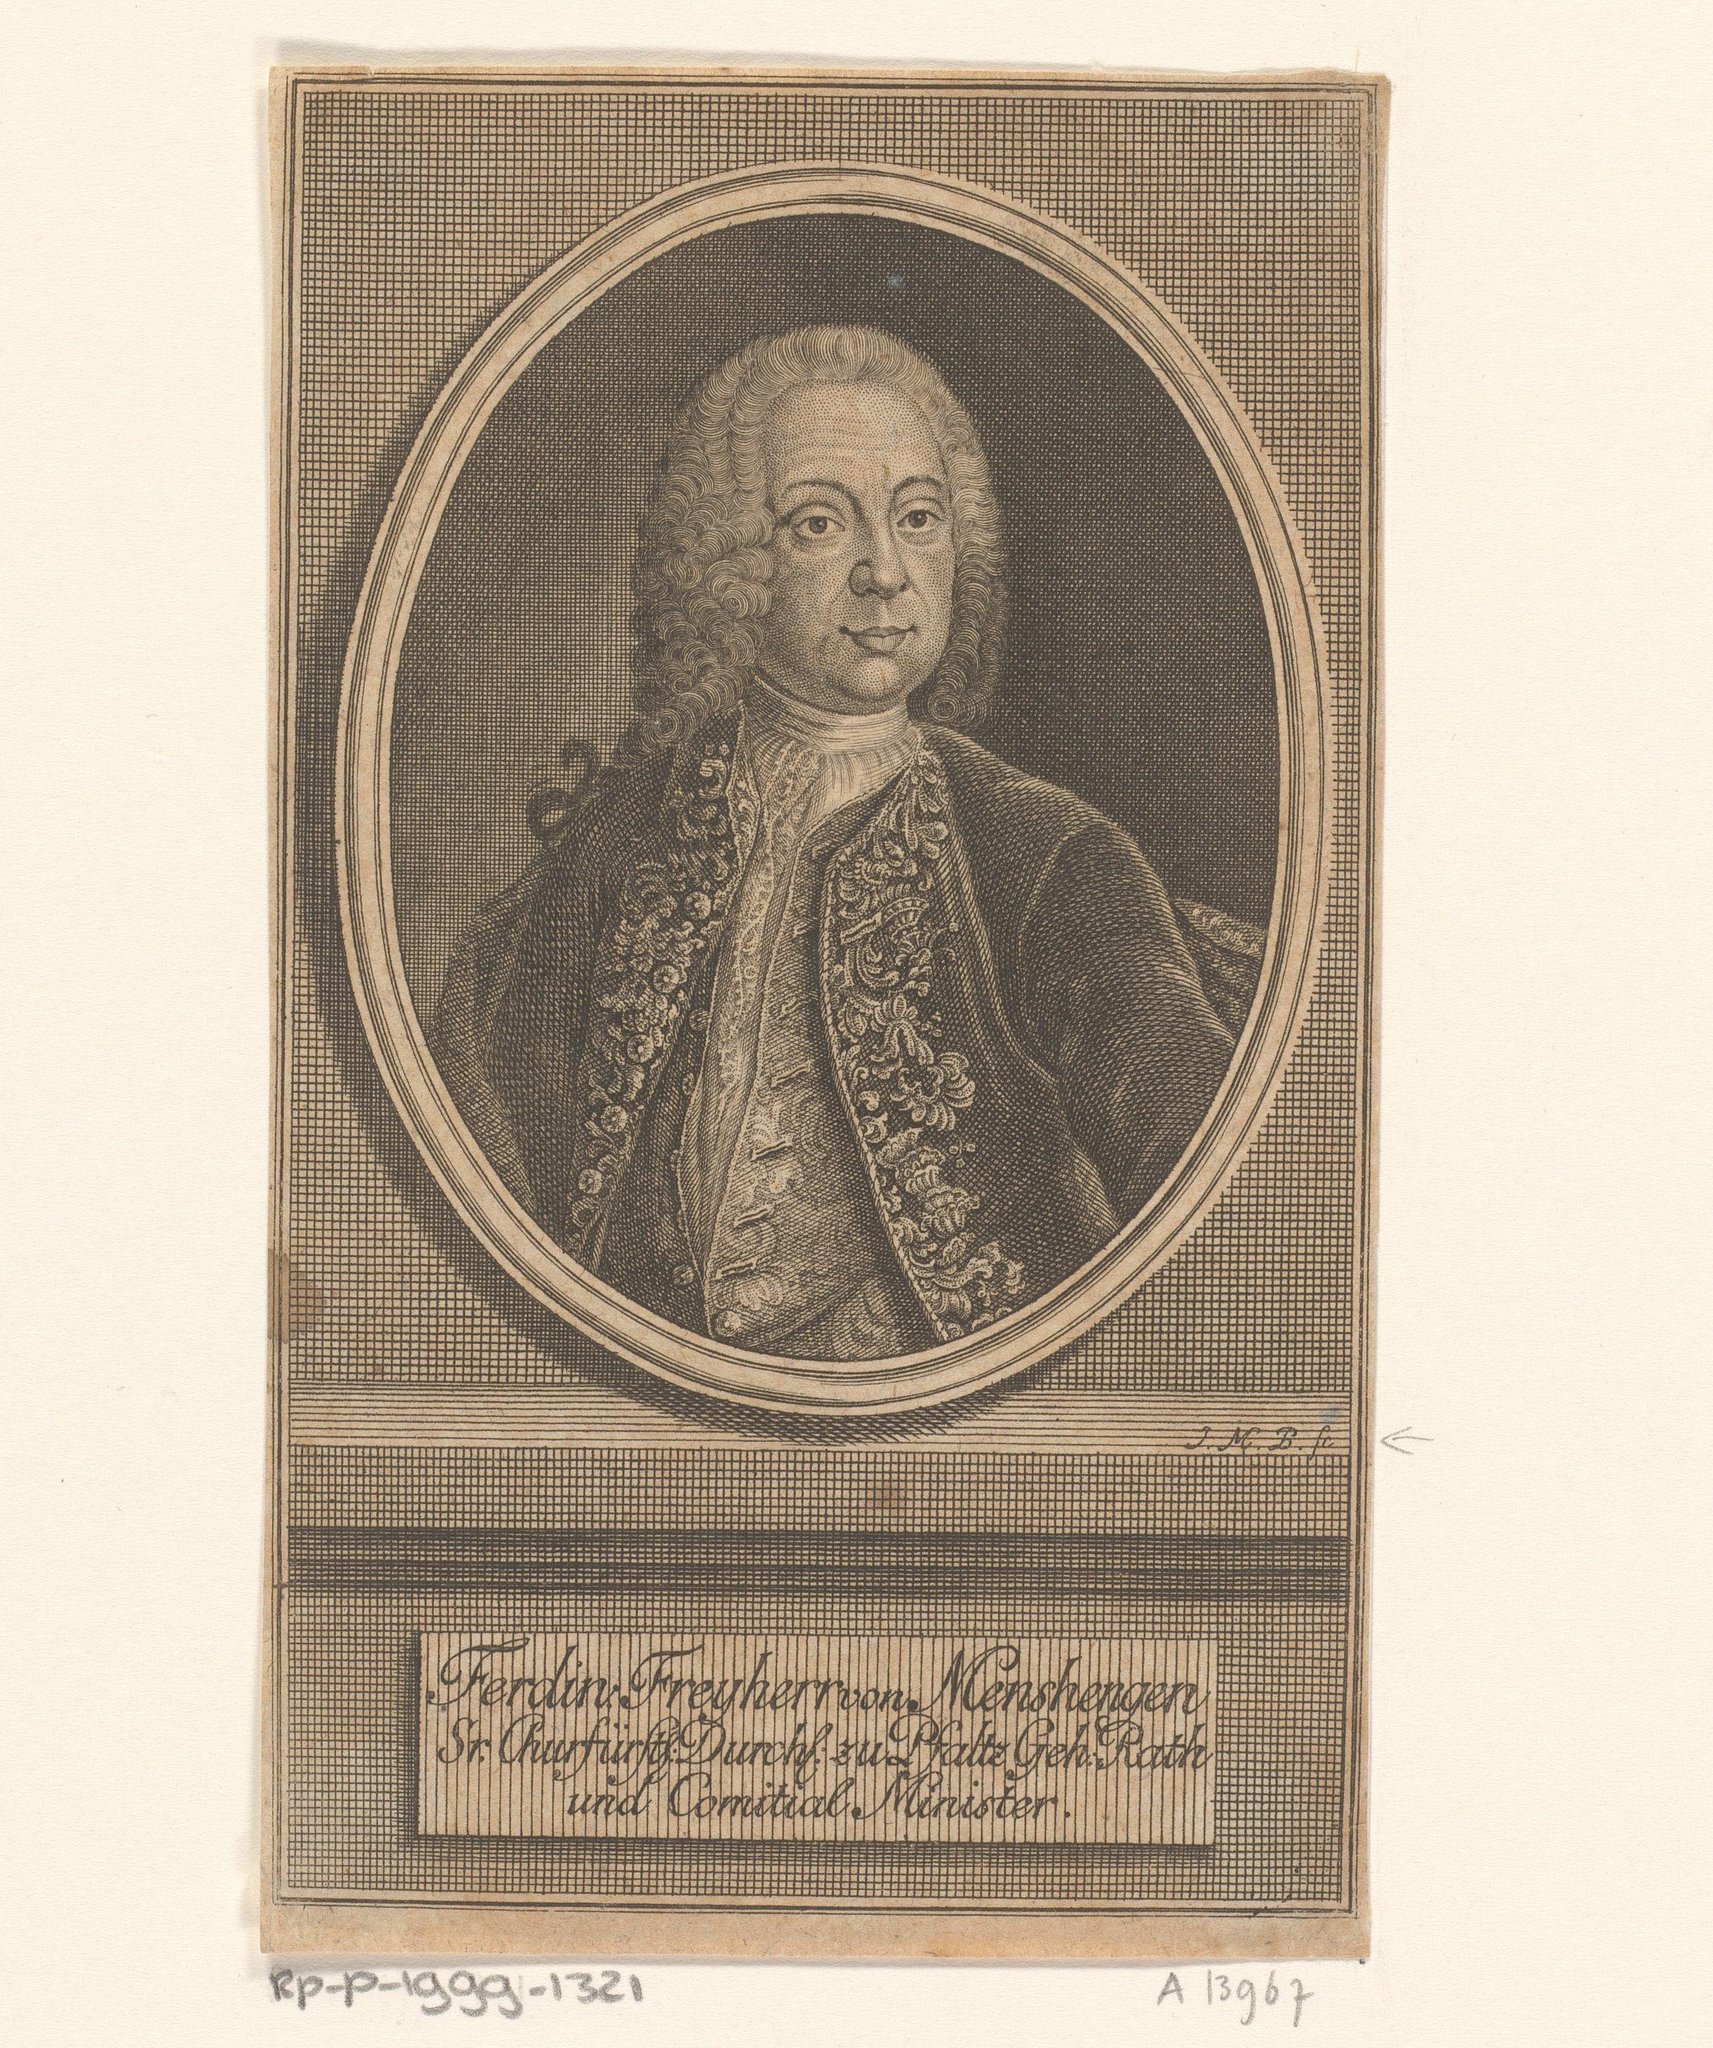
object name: print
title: Ferdin: Freyherr von Menshengen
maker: johann martin bernigeroth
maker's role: print maker, publisher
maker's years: 1713-1767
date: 1747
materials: paper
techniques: engraving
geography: leipzig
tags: historical persons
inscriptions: collector's mark: Lugt 2228, collector's mark: Lugt 2760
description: Prent waarschijnlijk uit: Die Neue Europäische Fama, Welche den gegenwärtigen Zustand der vornehmsten Höfe entdecket. S.l.s.n., 1747, dl. 148.